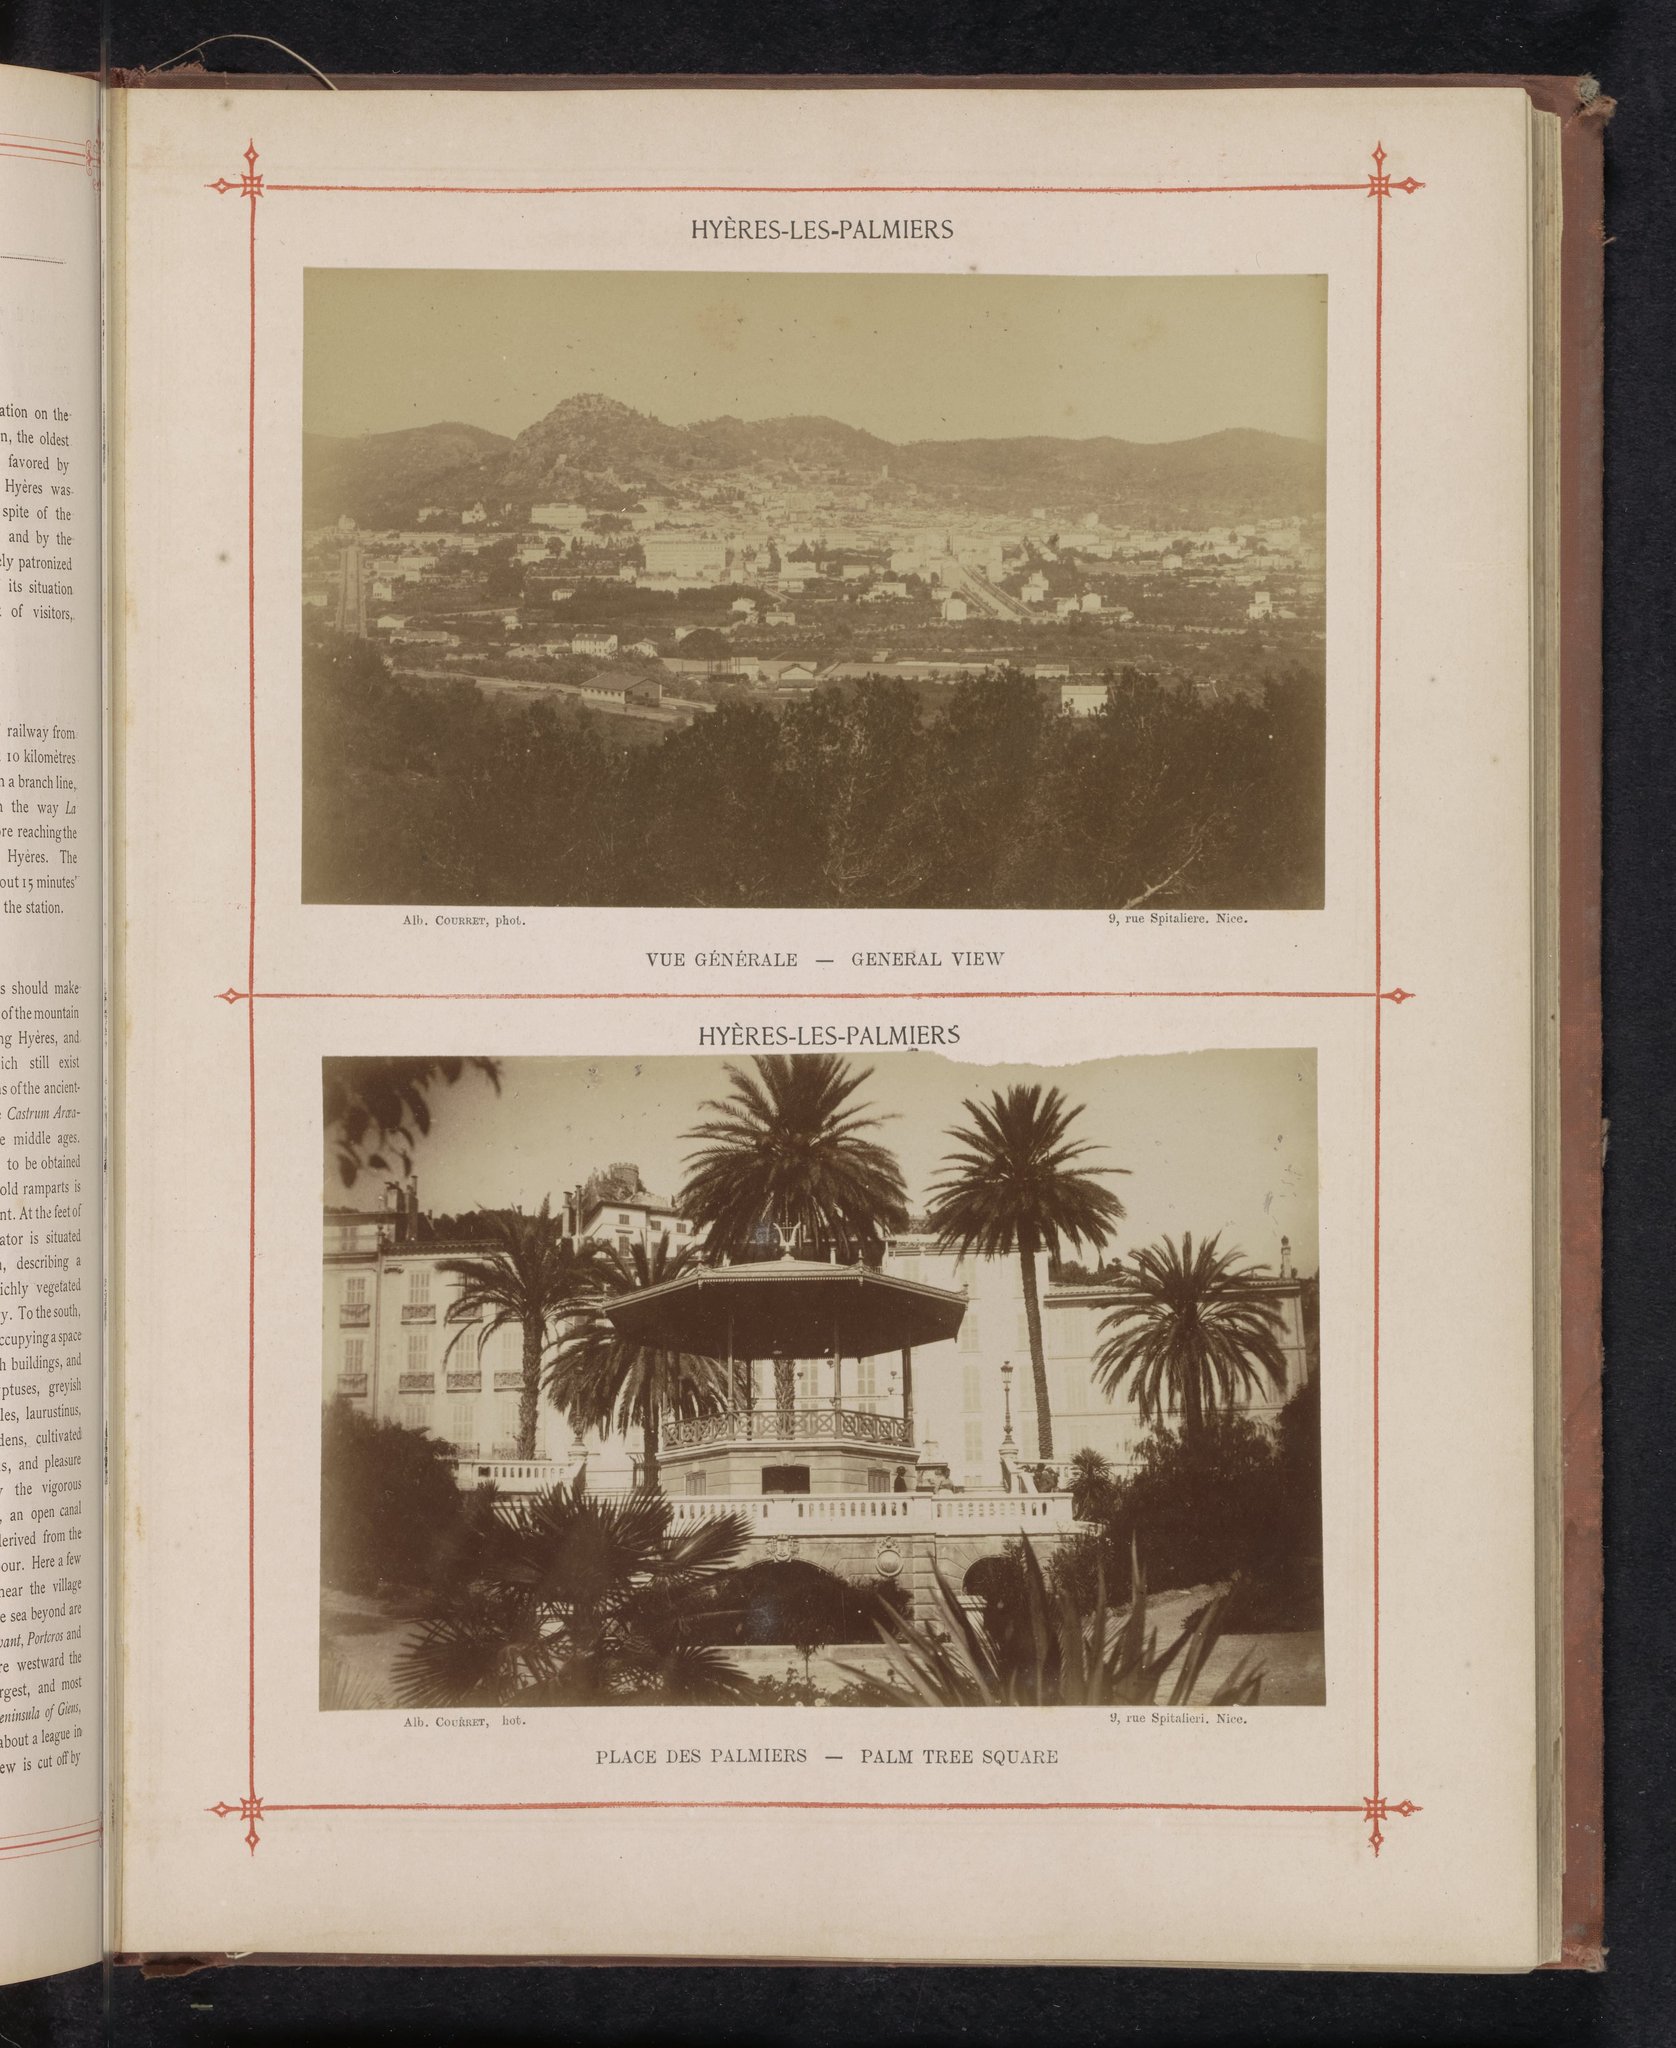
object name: photograph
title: General view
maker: albert courret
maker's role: fotograaf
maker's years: 1856-1928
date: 1876-1886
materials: photographic support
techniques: albumen print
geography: hyères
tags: city-view in general; 'veduta', bandstand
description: Boven een gezicht op Hyères, onder een muziekkoepel op een plein te Hyères.